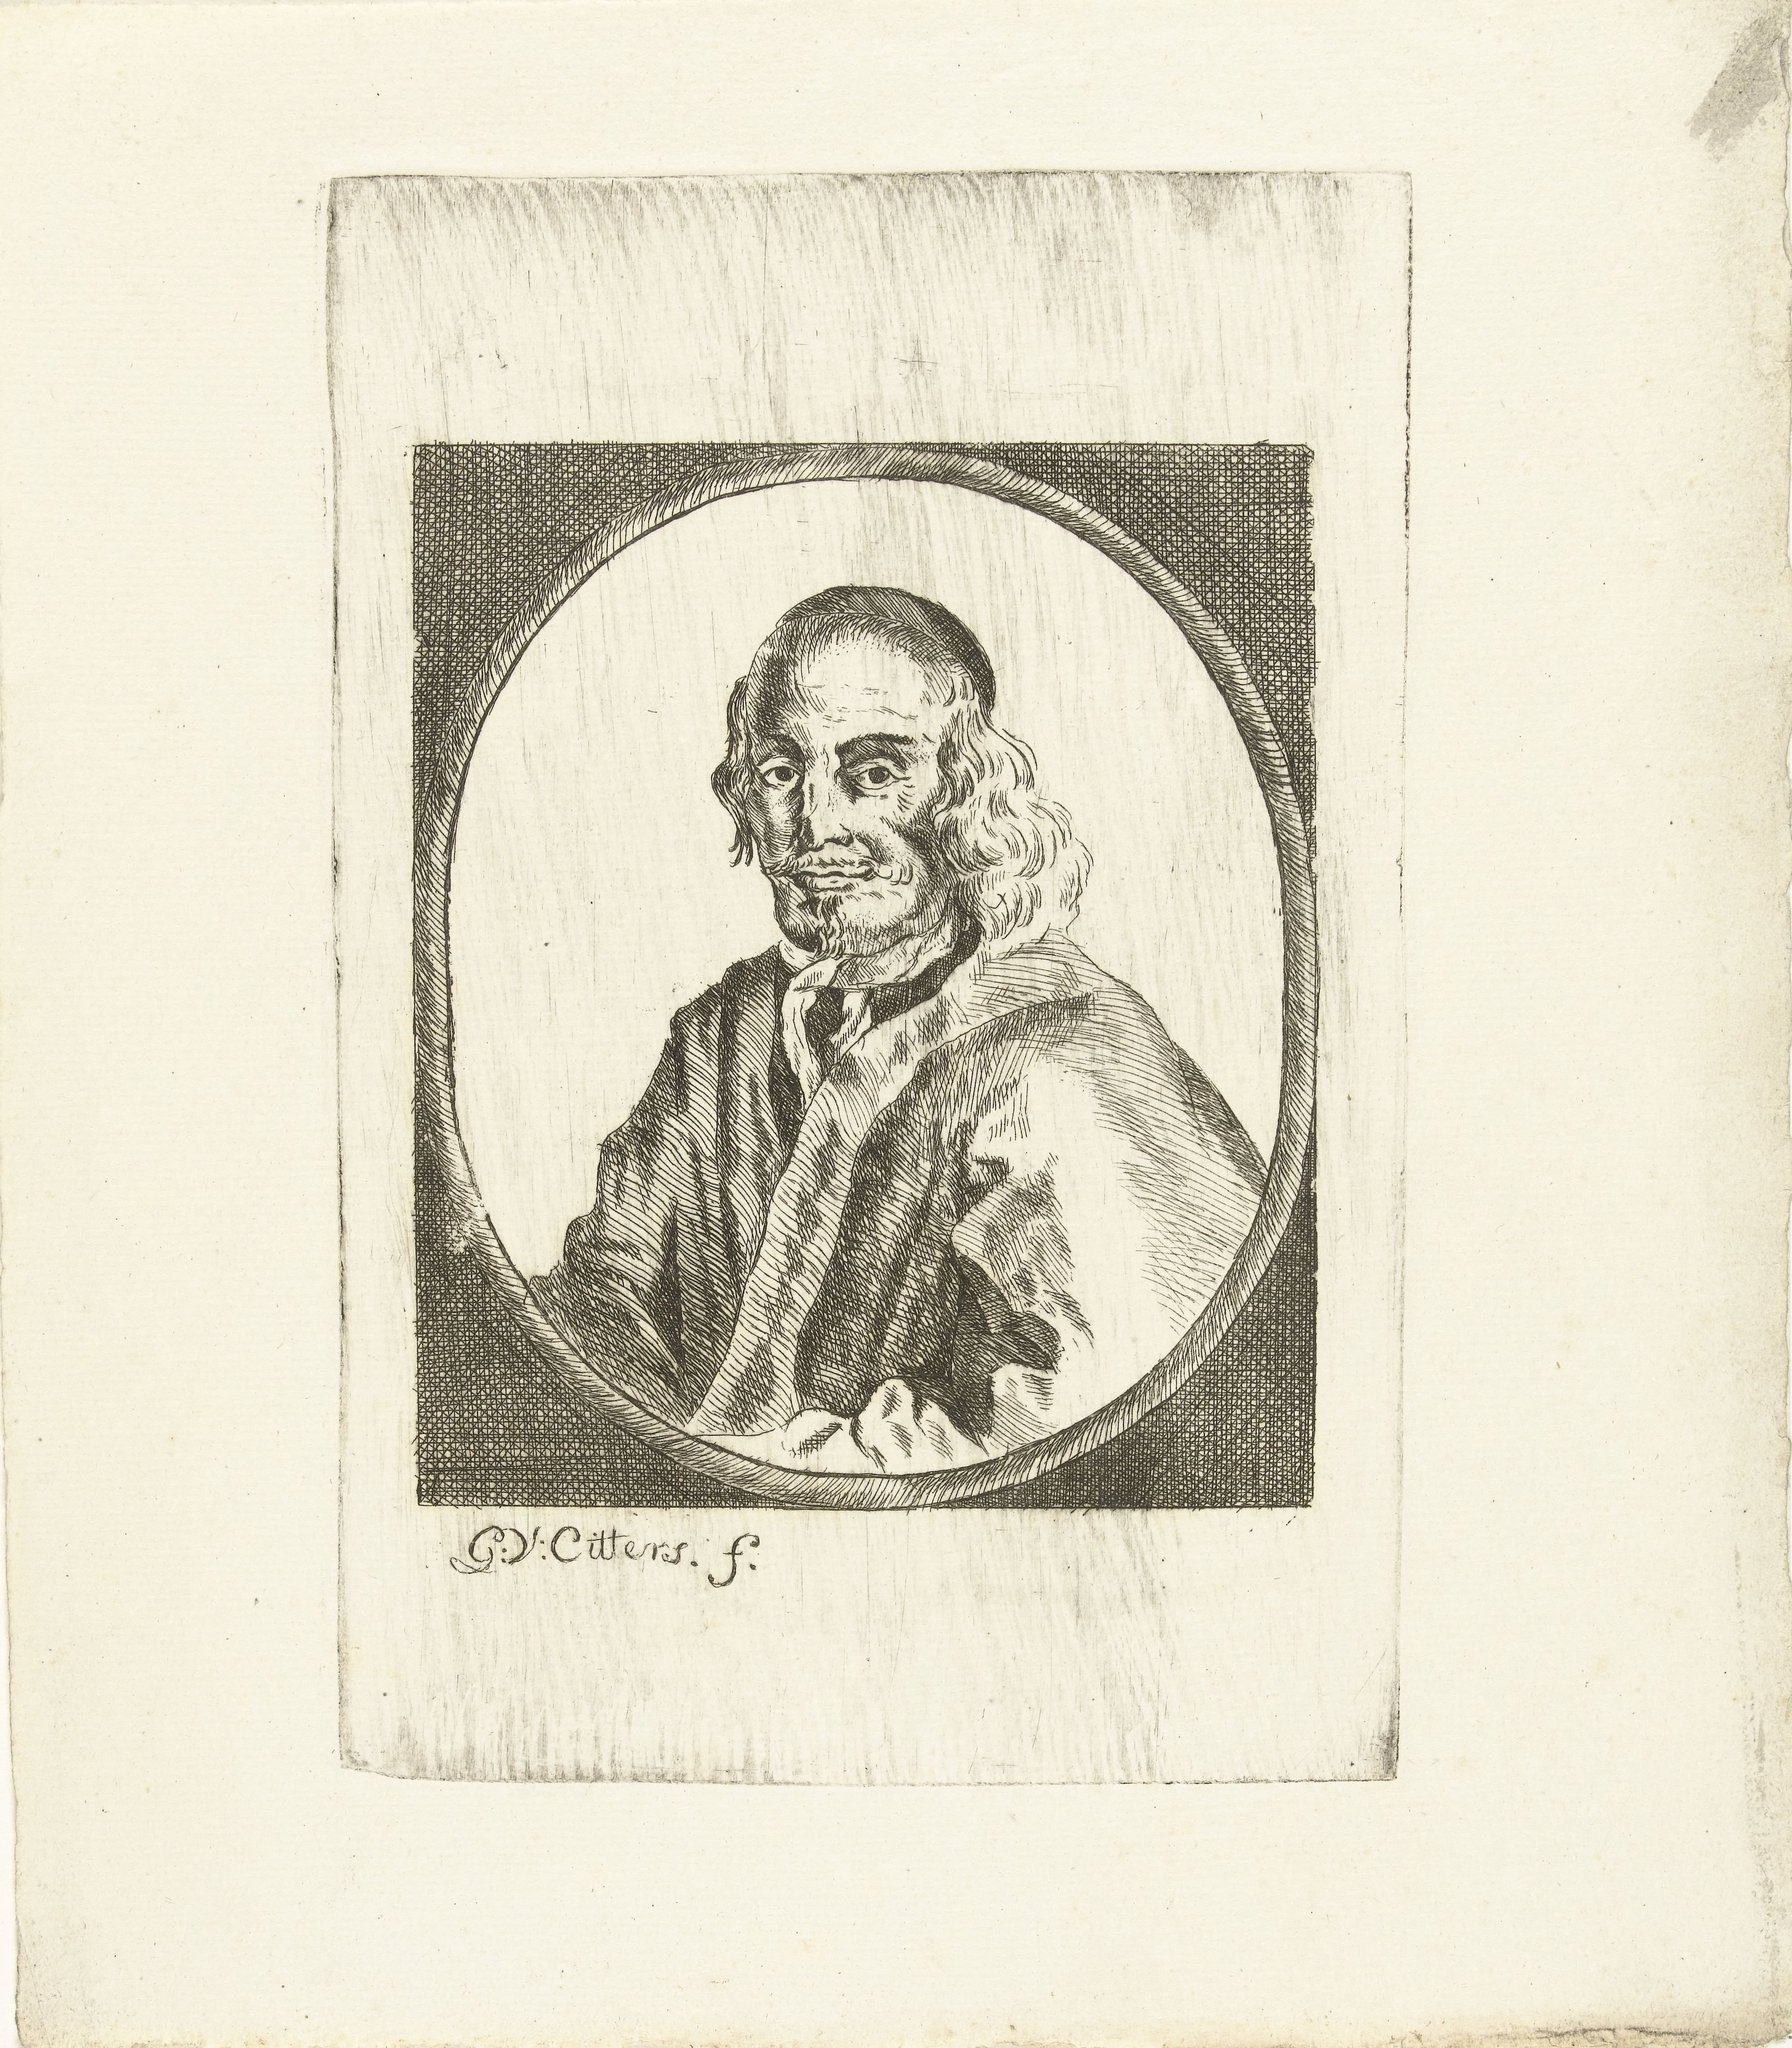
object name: print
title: Portret van een man met keppeltje, lang haar en baard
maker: g. van citters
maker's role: print maker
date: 1750-1800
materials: paper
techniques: etching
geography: netherlands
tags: head-gear, anonymous historical person portrayed alone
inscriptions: collector's mark: Lugt 2233